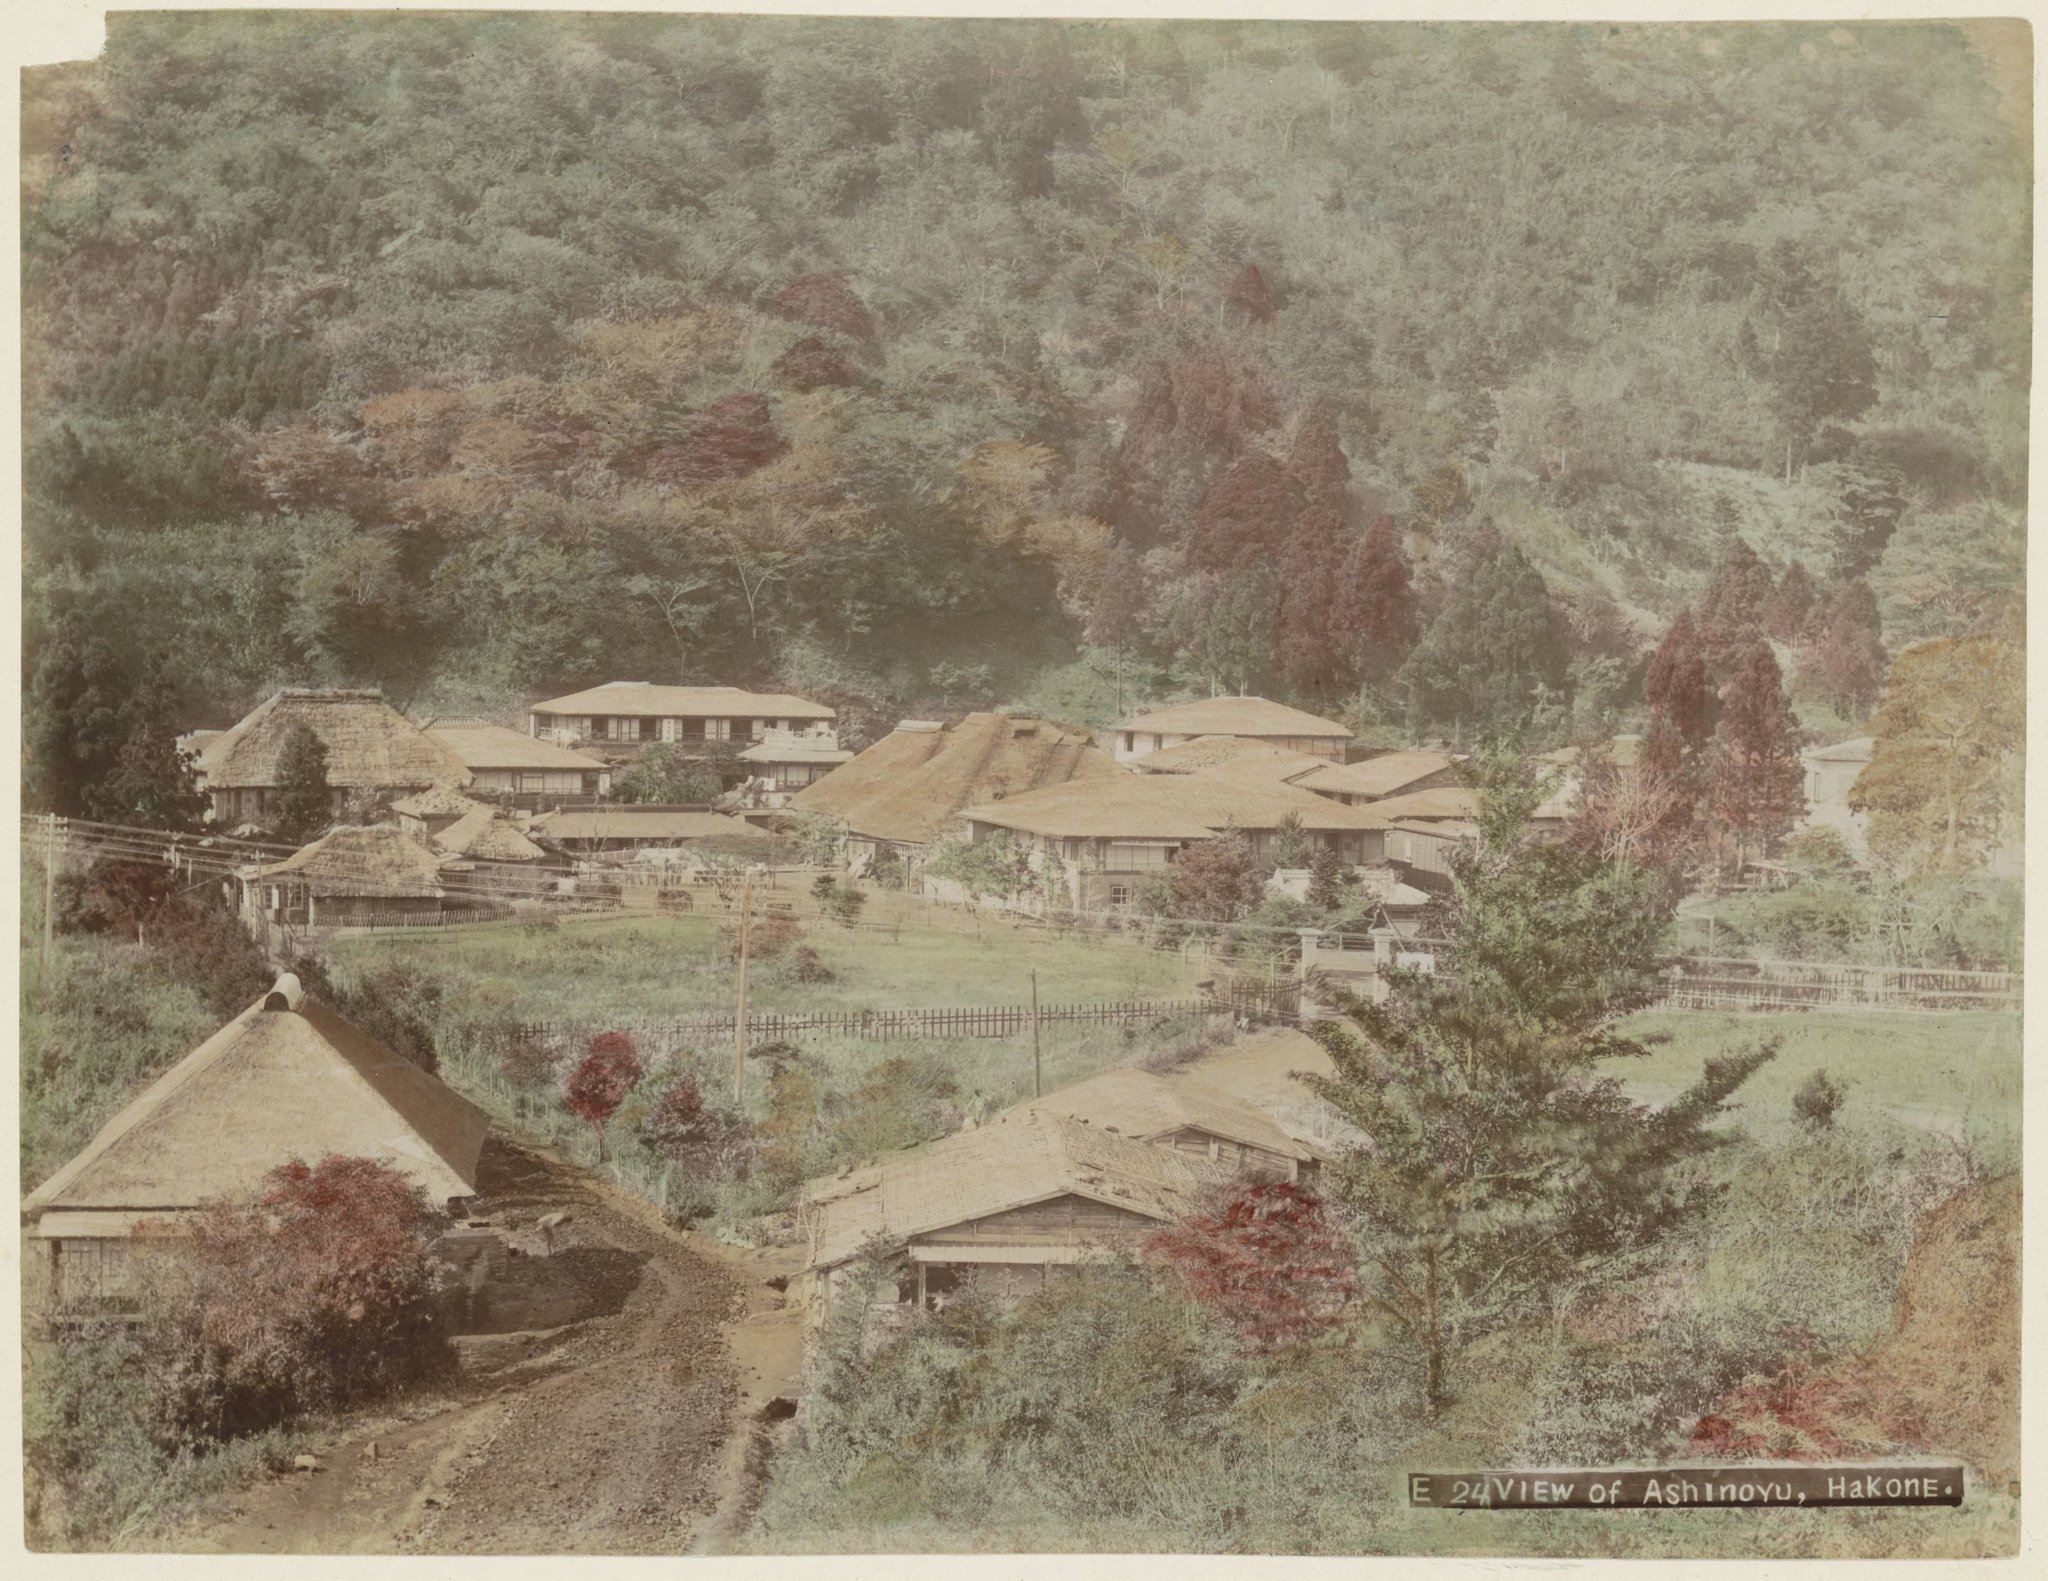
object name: photograph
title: View of Asinoyu, Hakone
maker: Anonymous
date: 1870-1900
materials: cardboard, paper, photographic support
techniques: albumen print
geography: hakone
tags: prospect of village, silhouette of village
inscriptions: negative number: ‘E 24’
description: Onderdeel van Reisalbum met foto's van bezienswaardigheden in Japan.